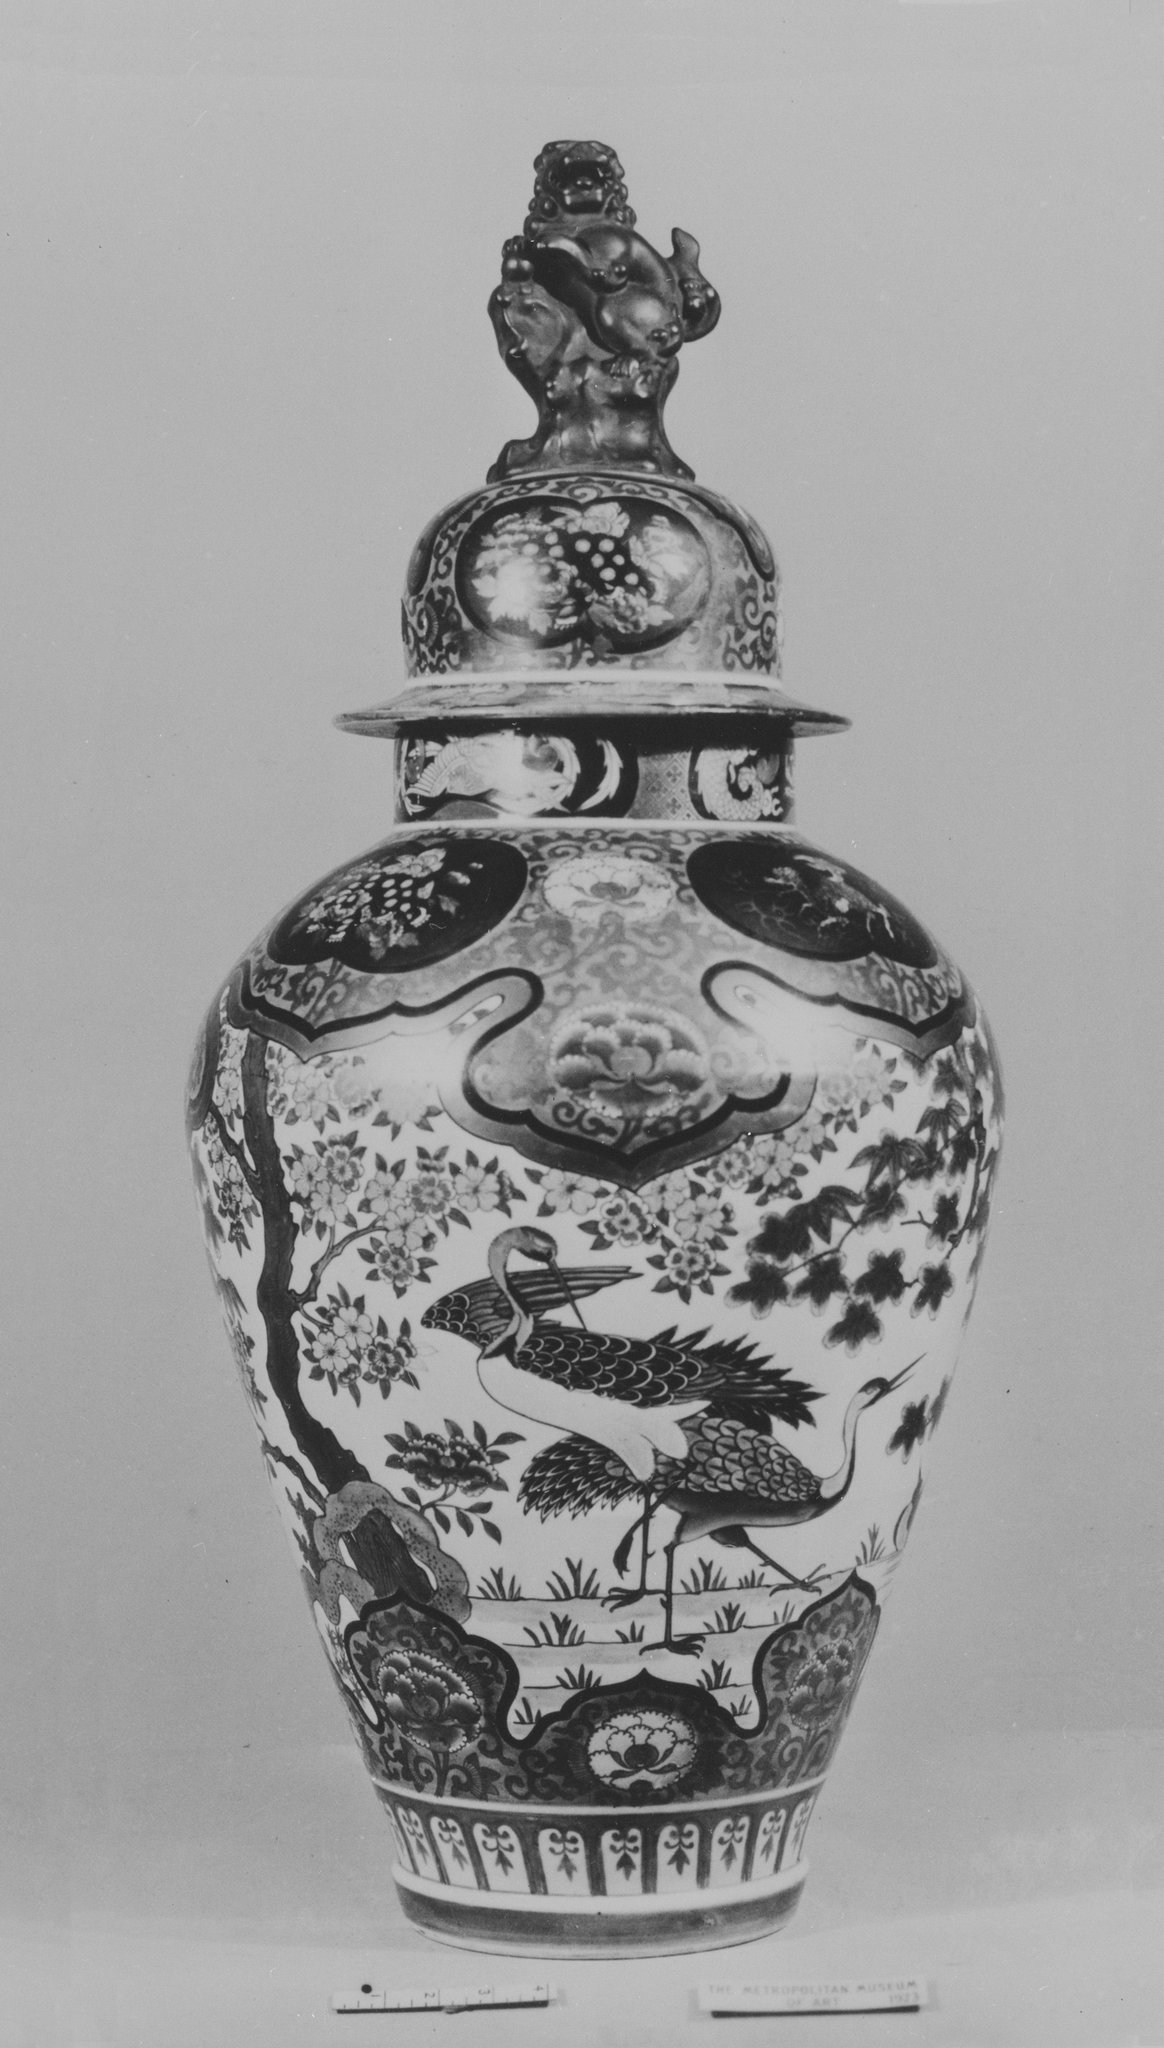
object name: vase with cover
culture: japanese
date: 1701-1800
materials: enamel, gold, porcelain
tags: cranes,flowers